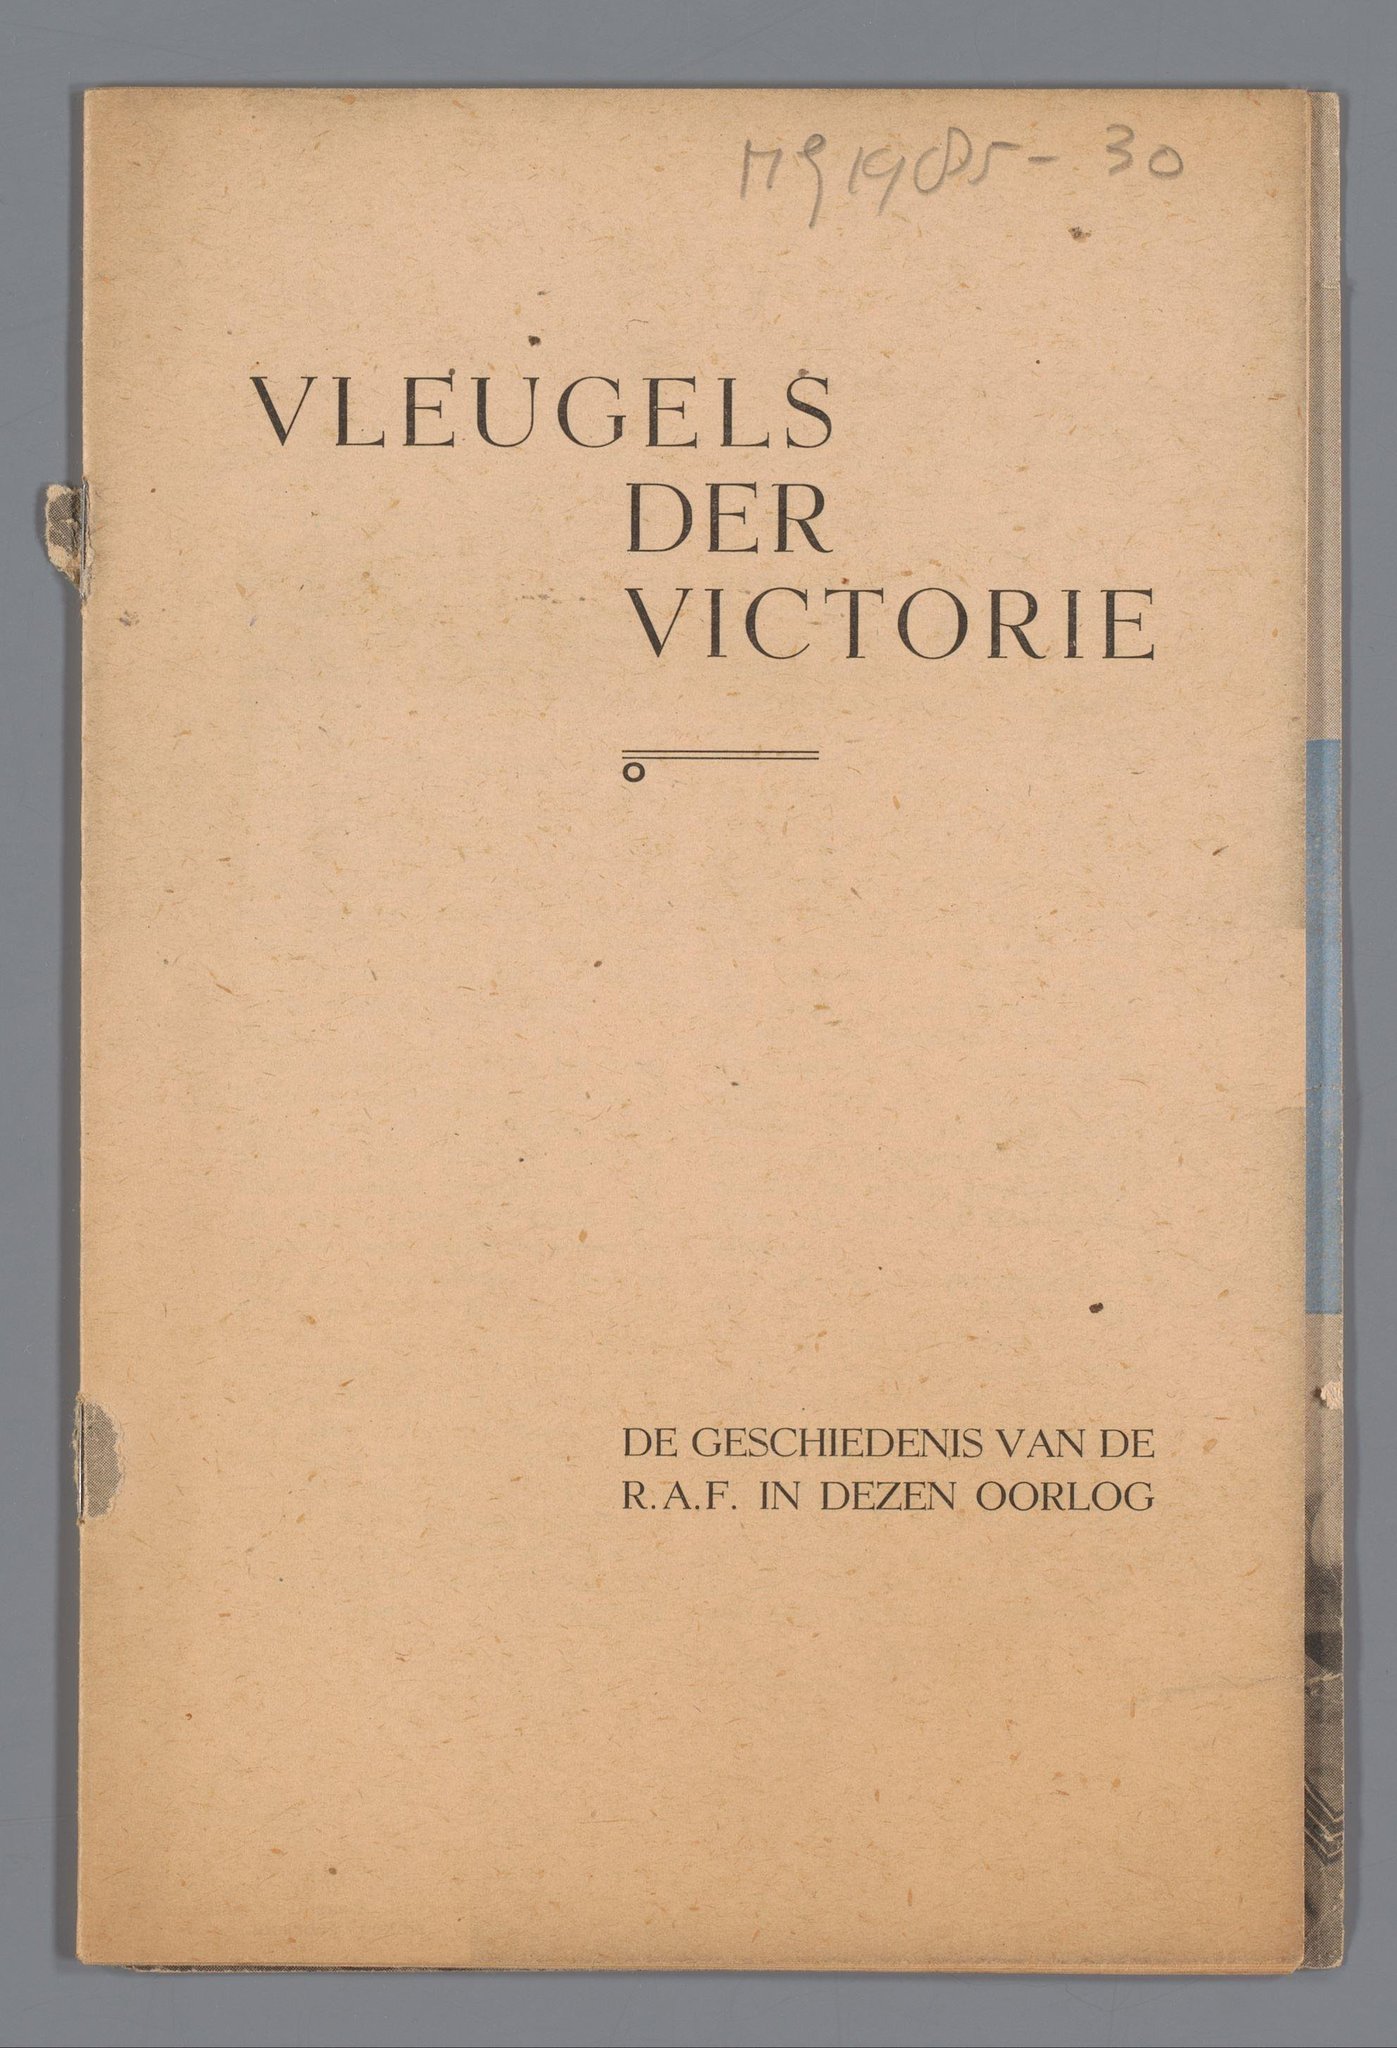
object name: brochure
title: Vleugels der victorie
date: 1945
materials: ink, paper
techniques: printing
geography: amsterdam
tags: england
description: Brochure over de geschiedenis van de RAF in de Tweede Wereldoorlog, 32 pagina's.